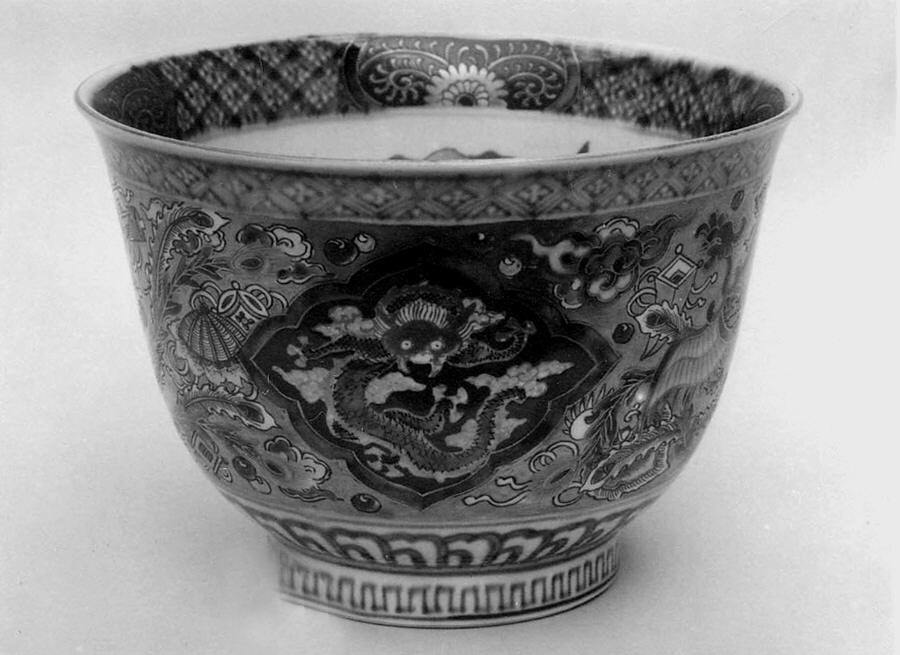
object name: bowl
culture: japanese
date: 1701-1900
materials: gilt, porcelain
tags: dragons